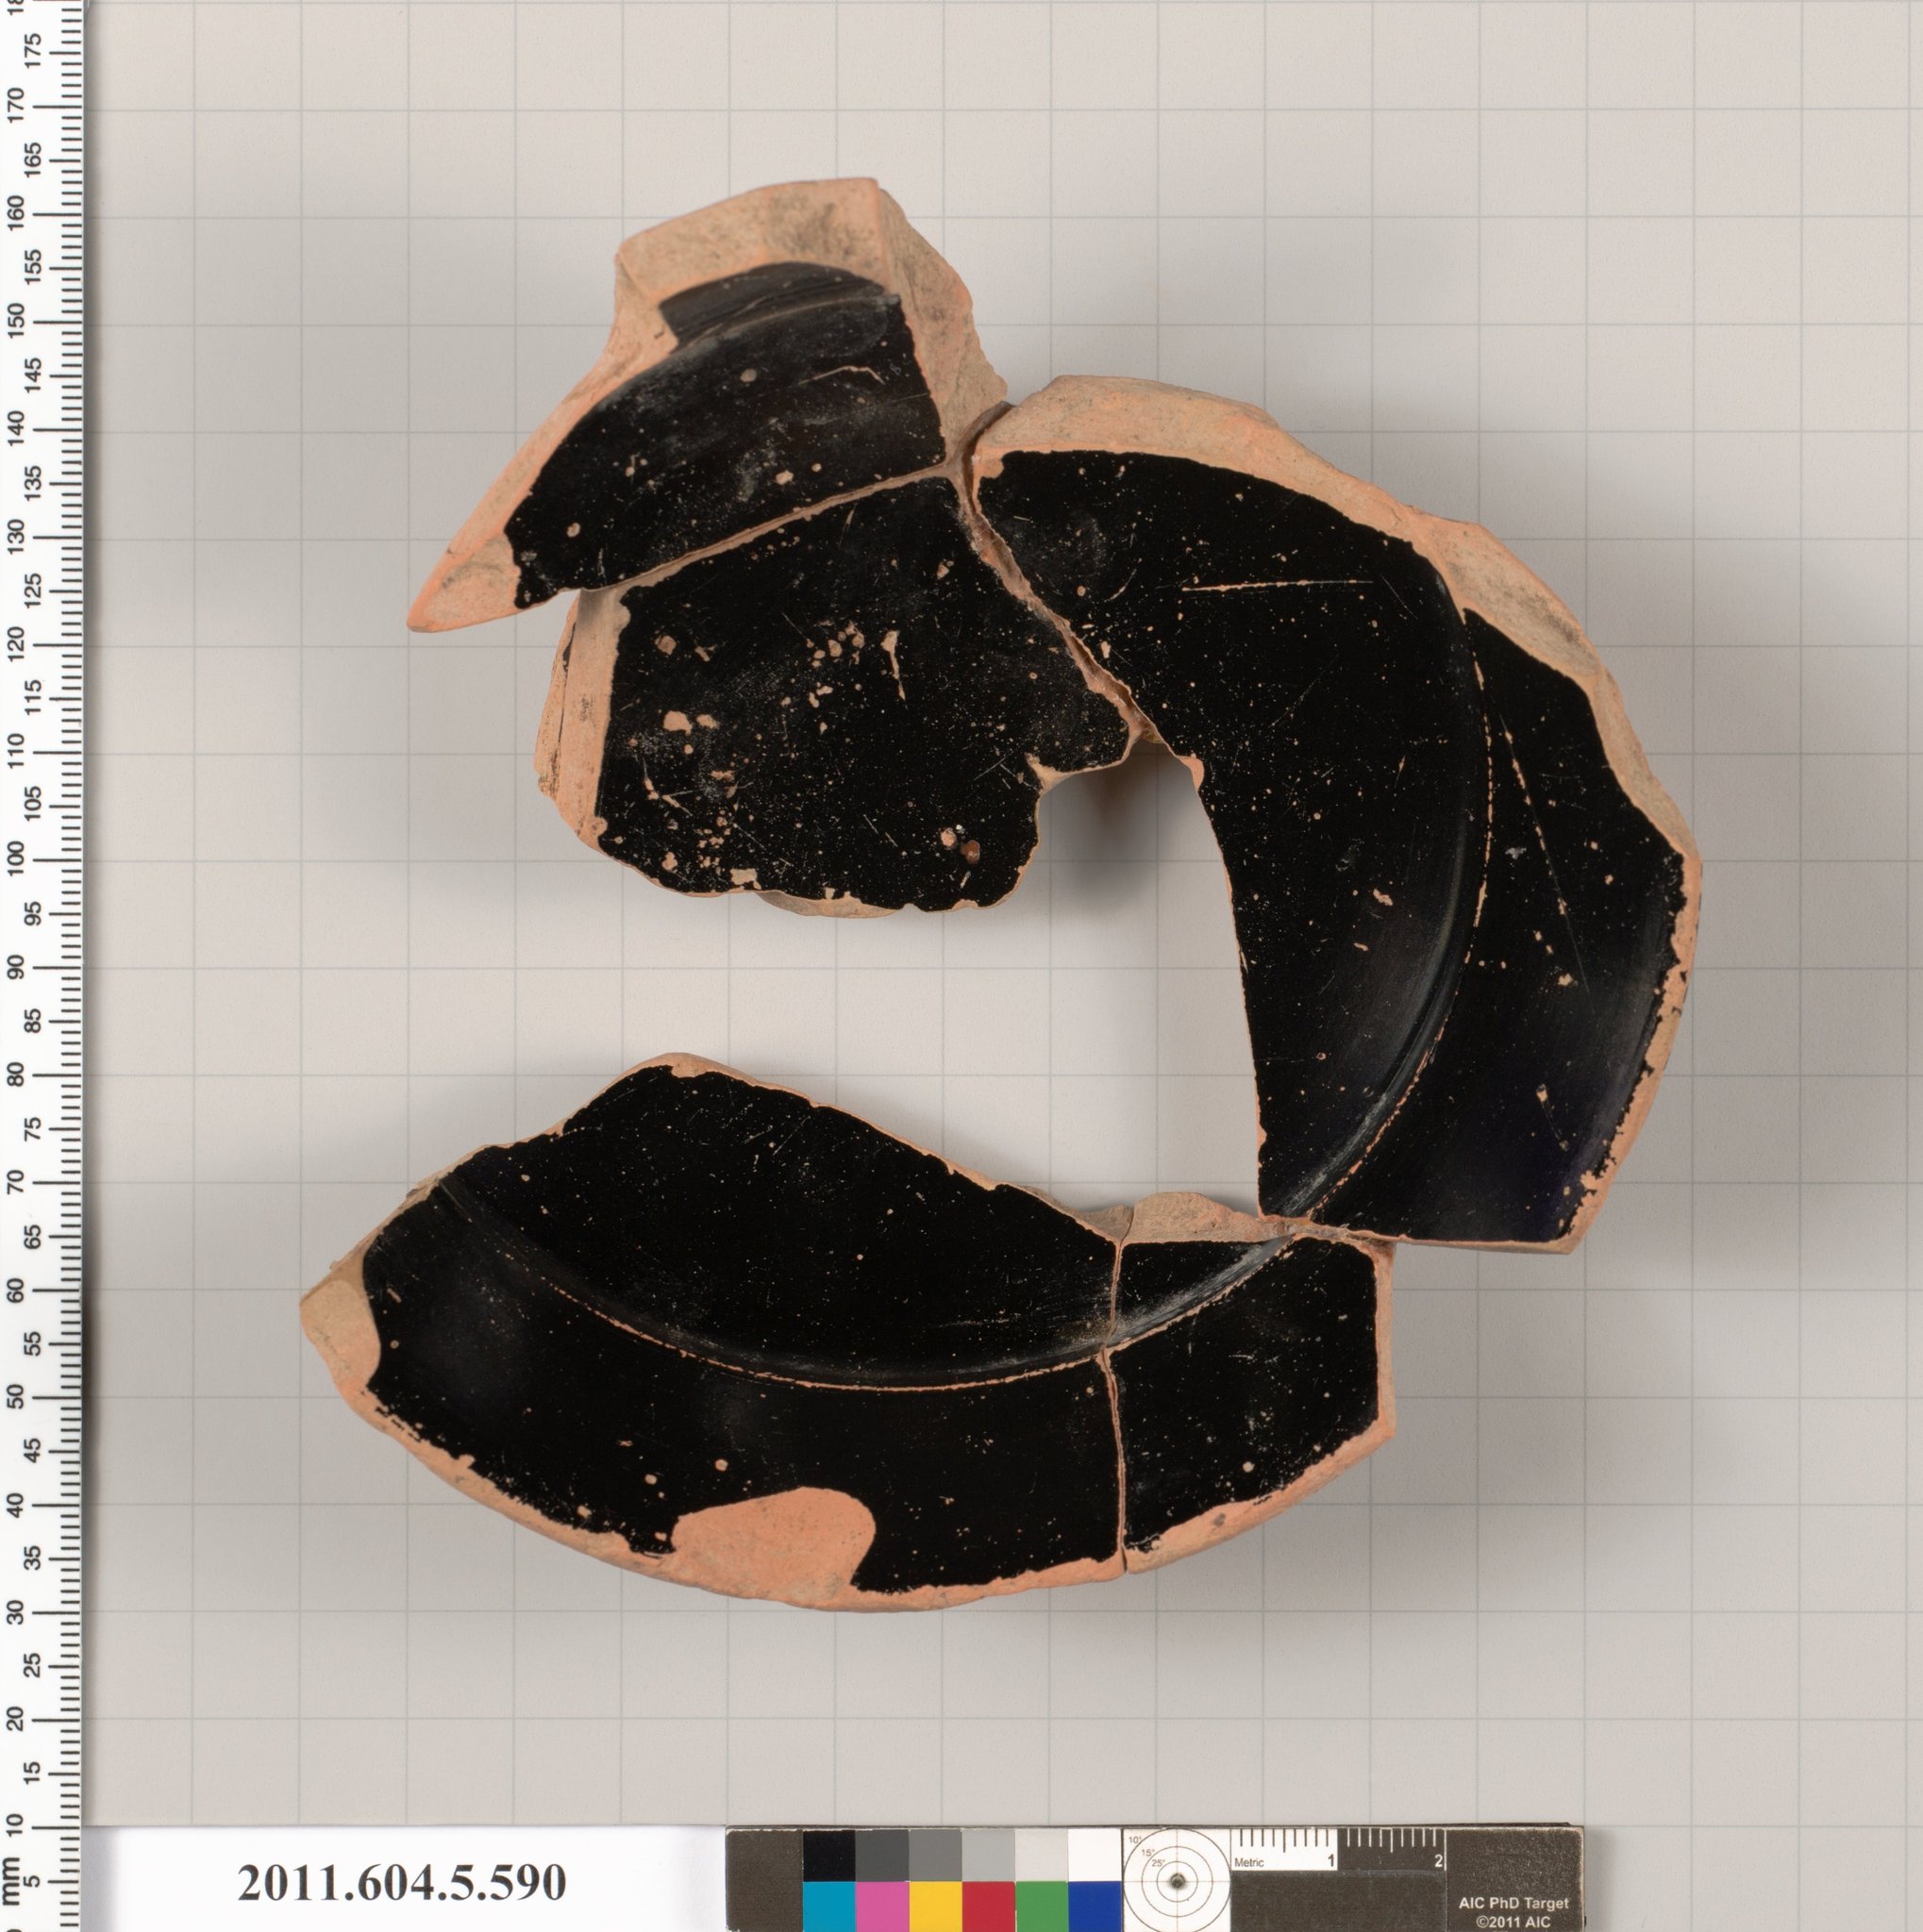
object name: stemless kylix fragment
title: Terracotta fragment of a stemless kylix (drinking cup)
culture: greek, attic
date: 600-401 BCE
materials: terracotta